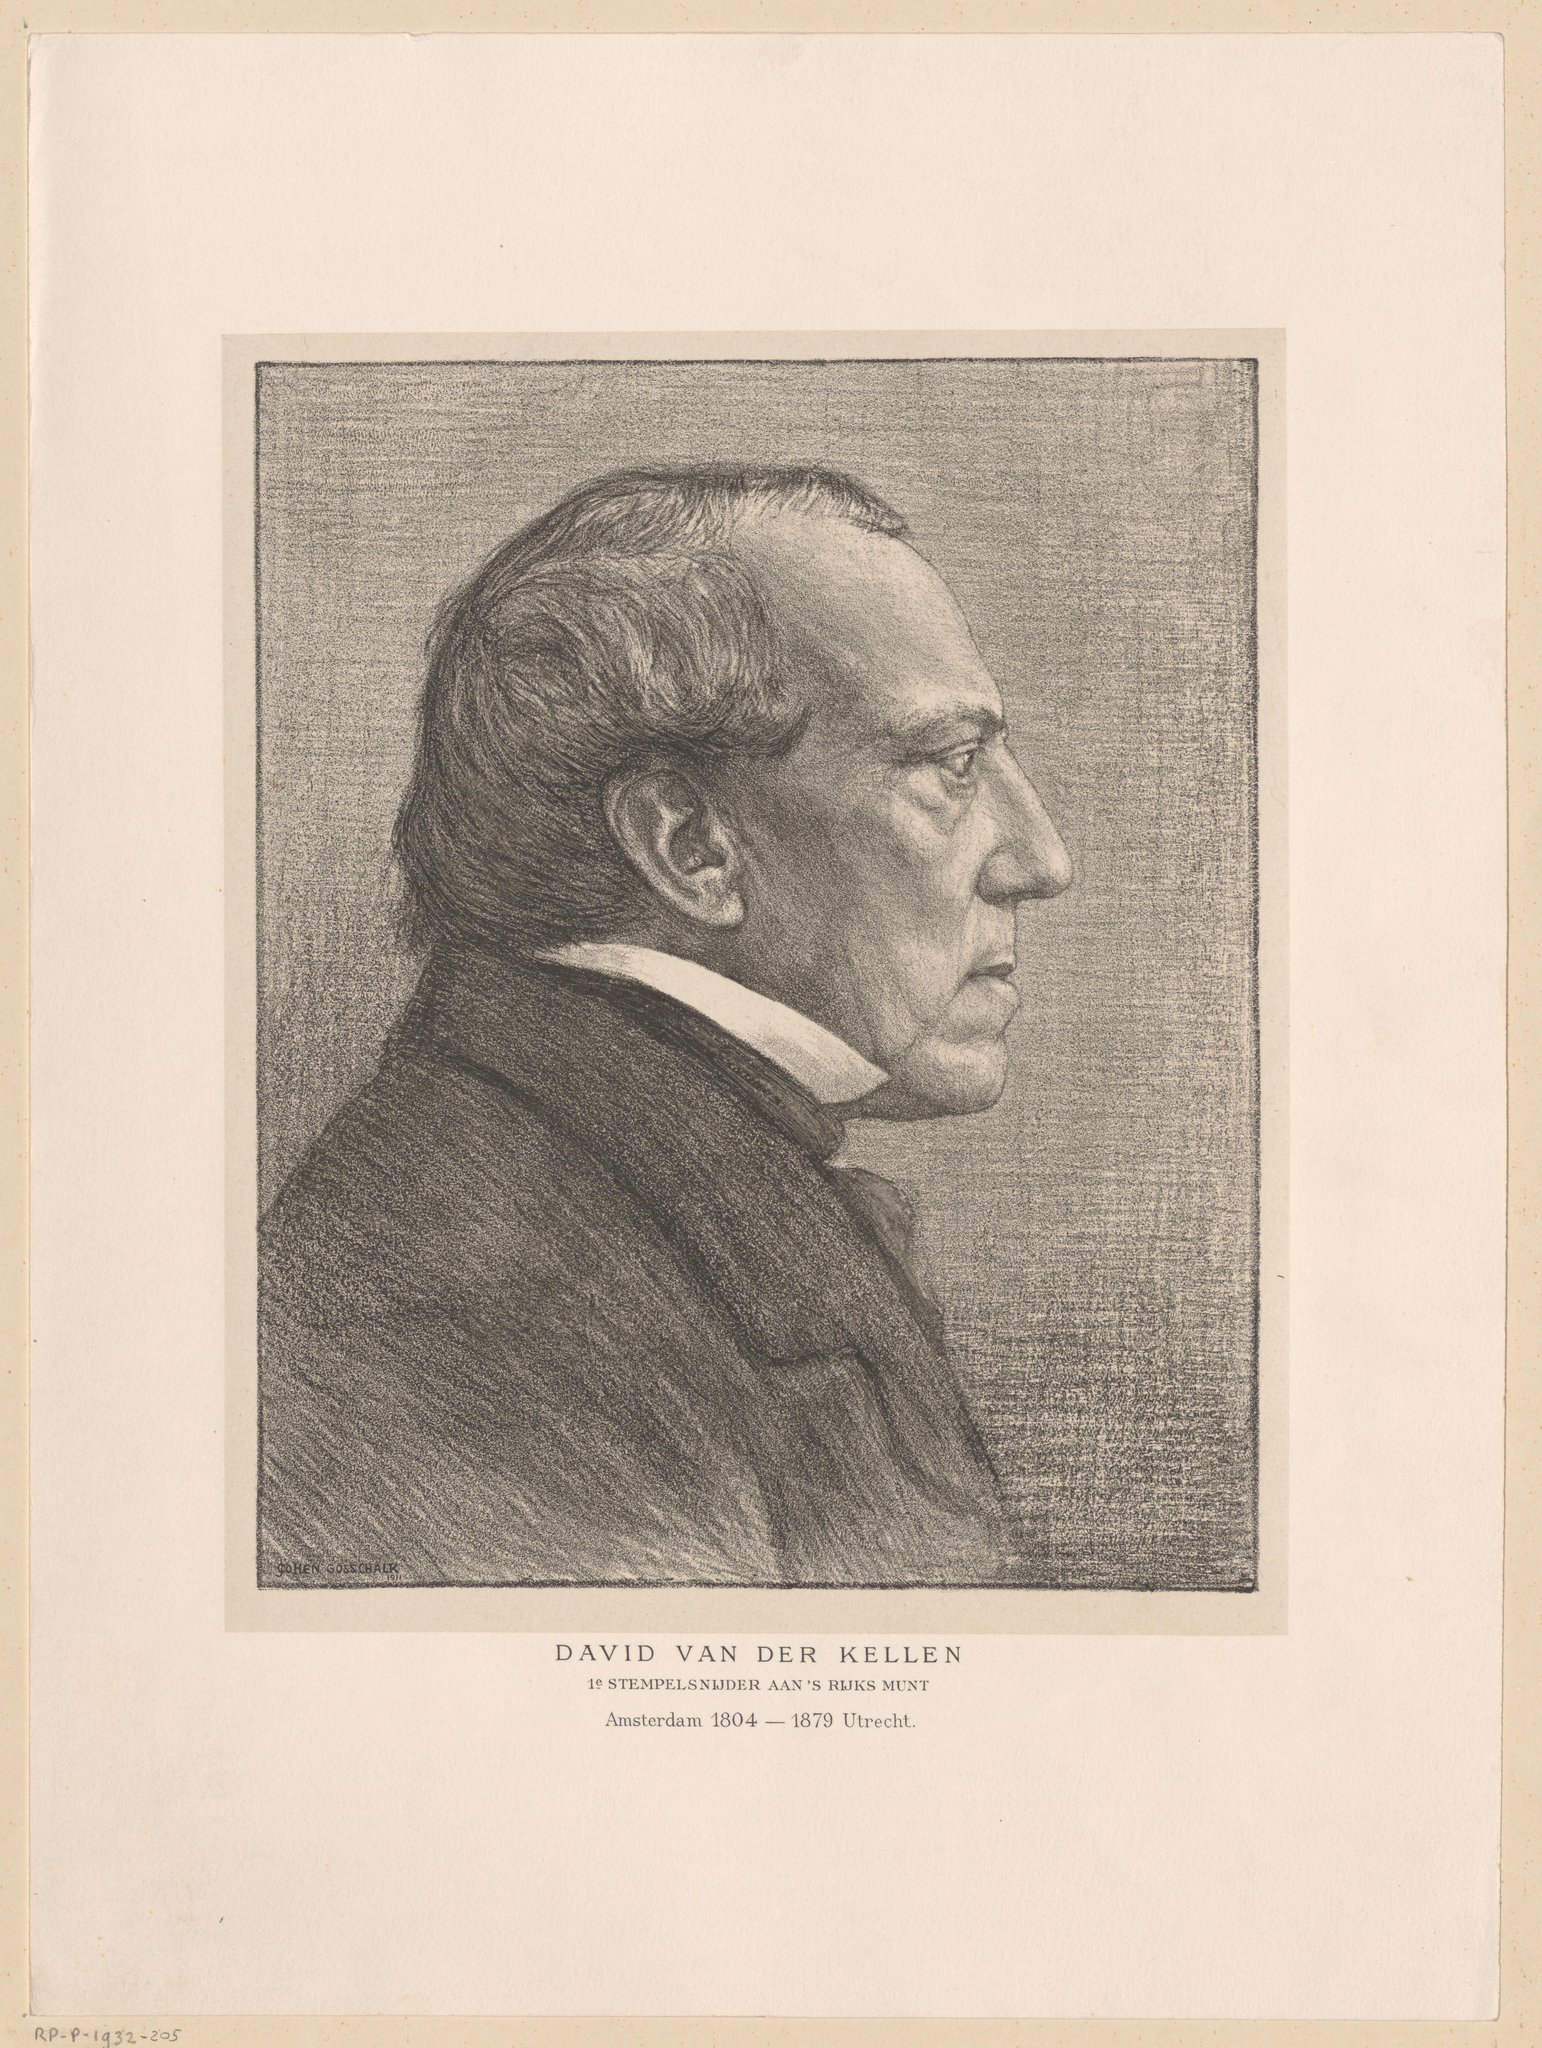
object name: print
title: Portret van David van der Kellen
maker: johan henri gustaaf cohen gosschalk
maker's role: draughtsman, print maker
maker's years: 1873-1912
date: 1911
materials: paper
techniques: lithograph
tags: amsterdam, utrecht, print maker, draughtsman, die cutter, david van der kellen (1804-1879), historical persons, portrait, self-portrait of artist